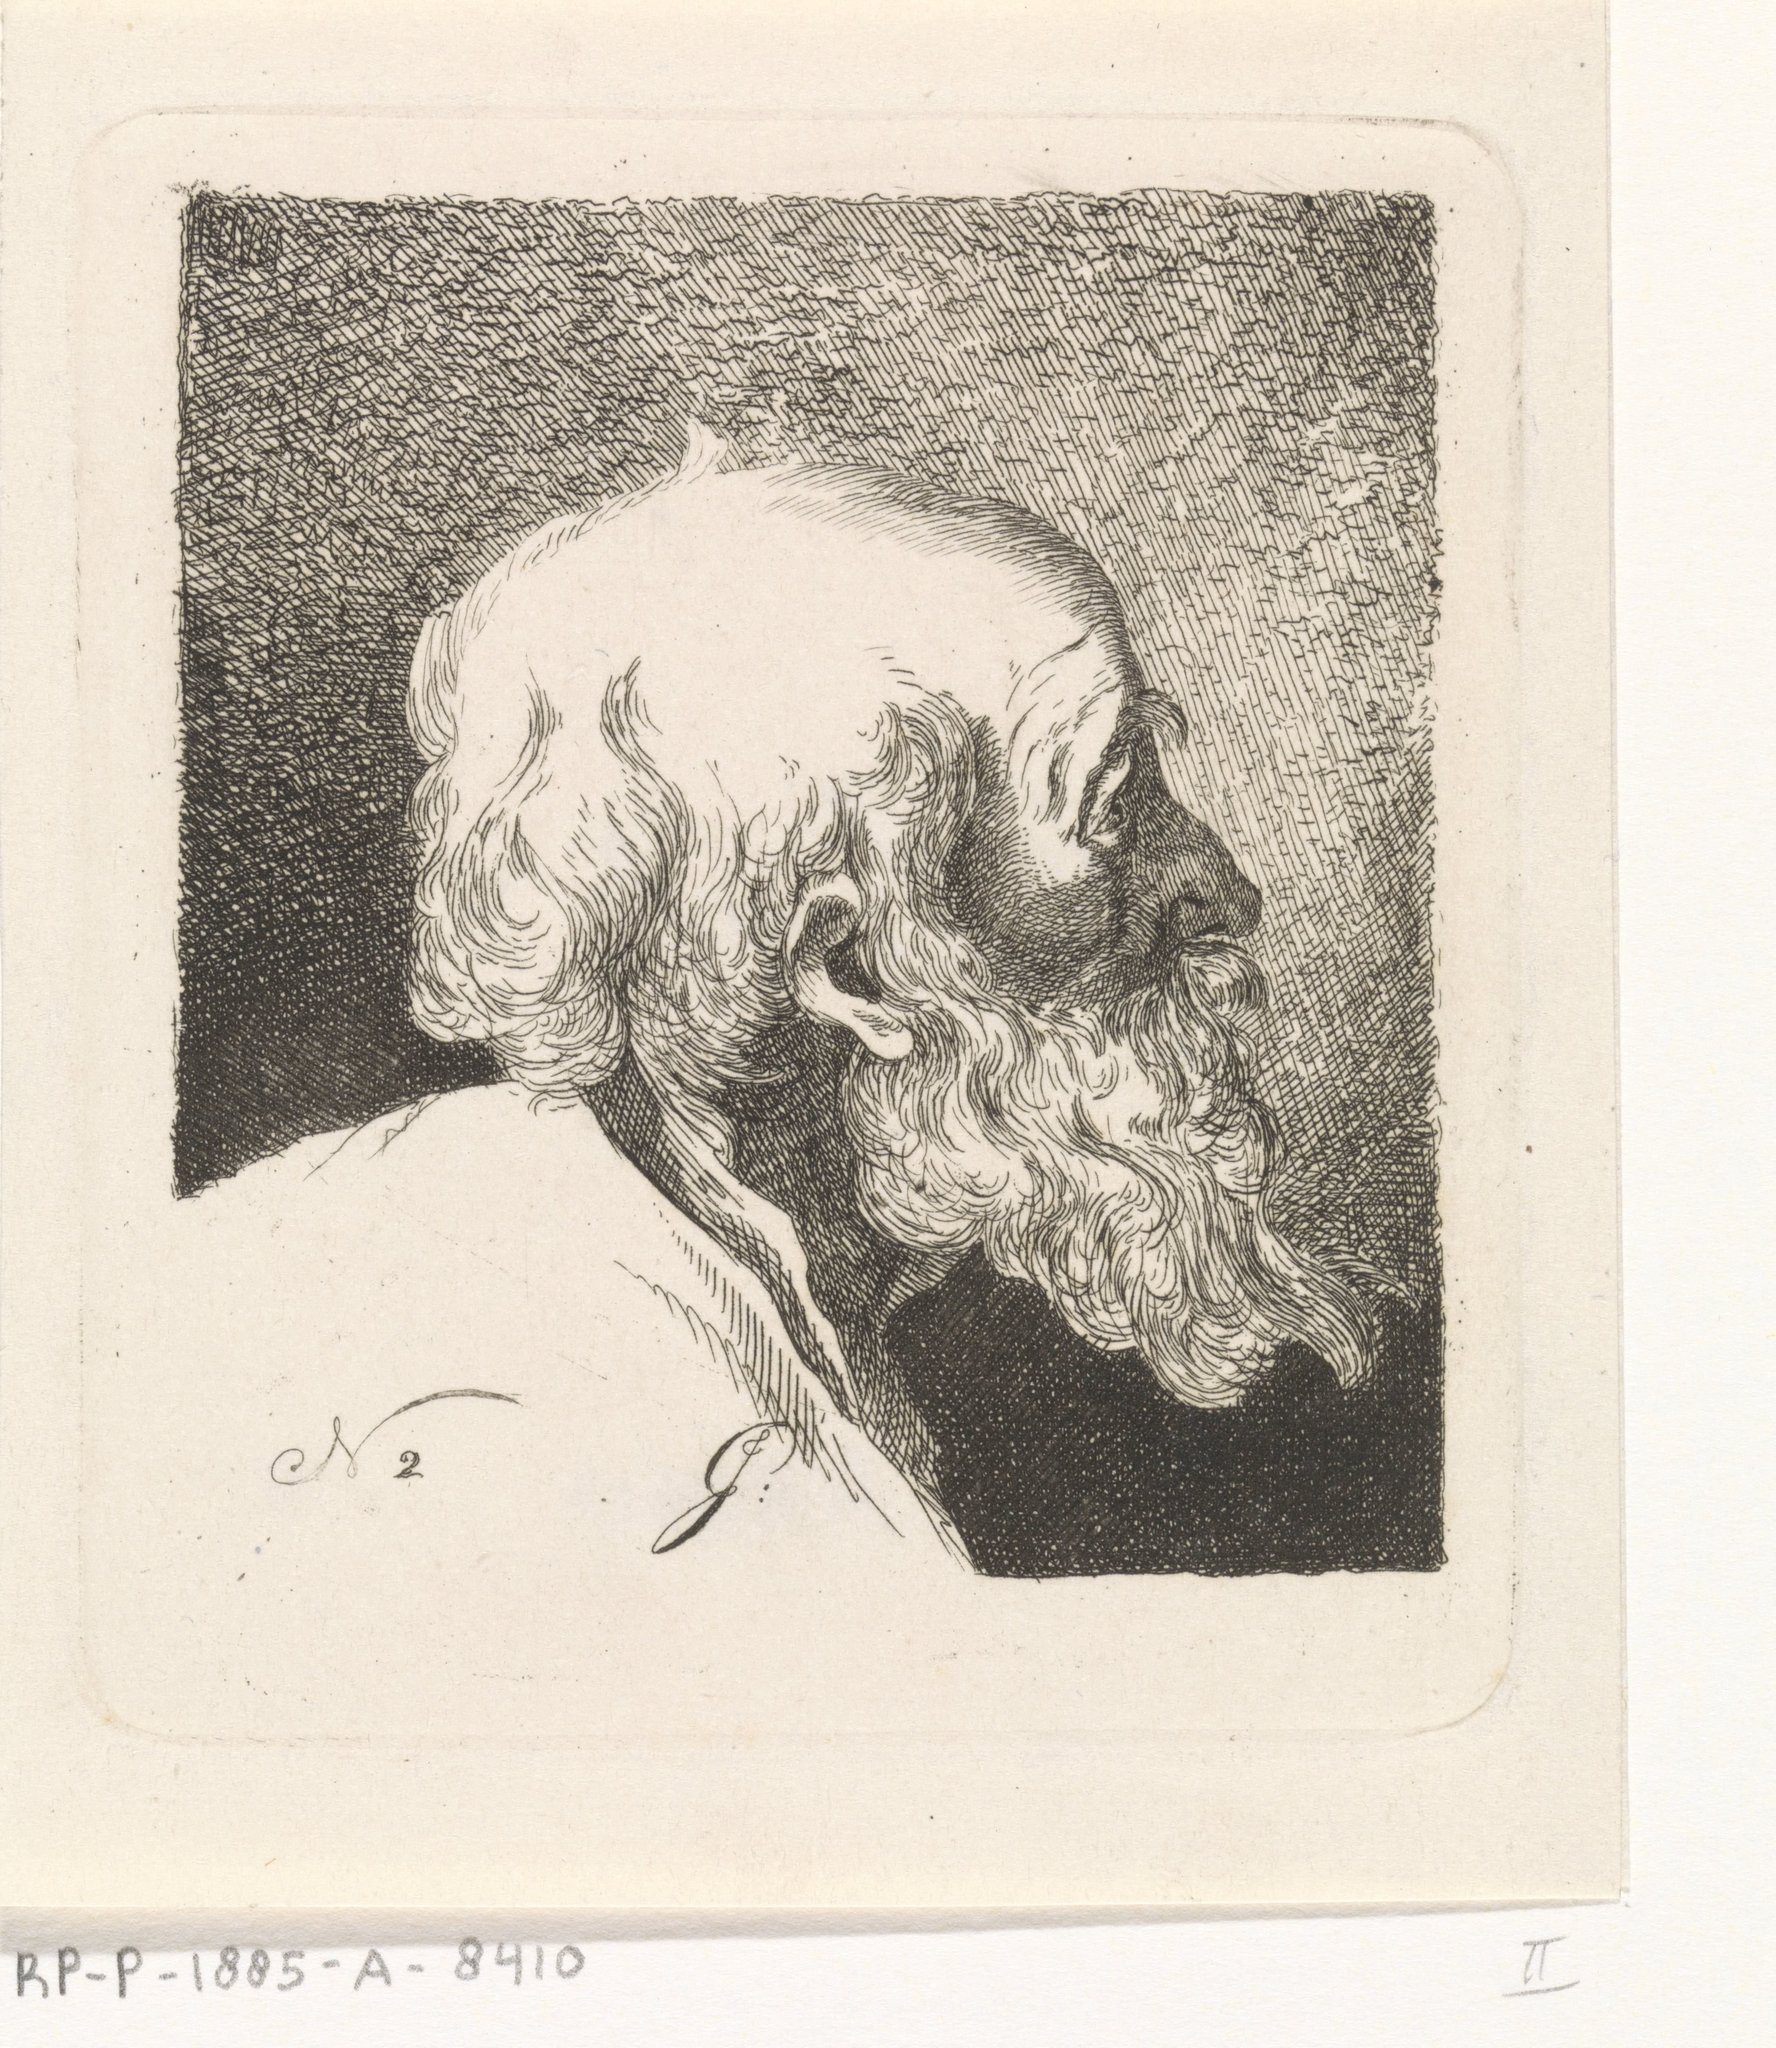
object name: print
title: Portret van een oude man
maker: george jooss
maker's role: print maker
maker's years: 1799-1845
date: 1834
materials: paper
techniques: etching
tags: old man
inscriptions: collector's mark: Lugt 2228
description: Portretbuste van een oude man met baard.